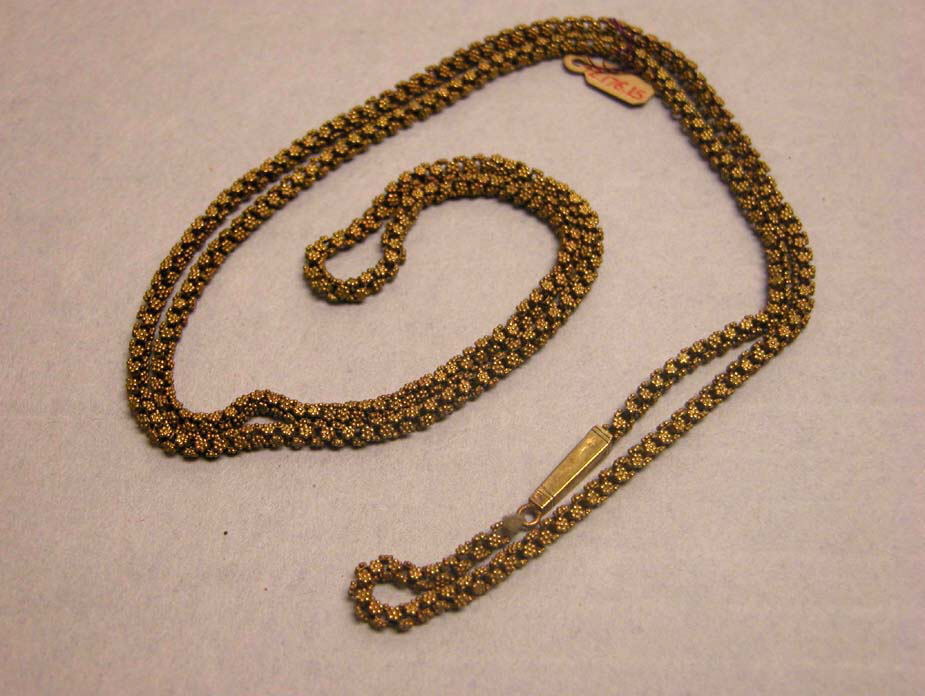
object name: necklace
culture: filipino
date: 1601-1900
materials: gold